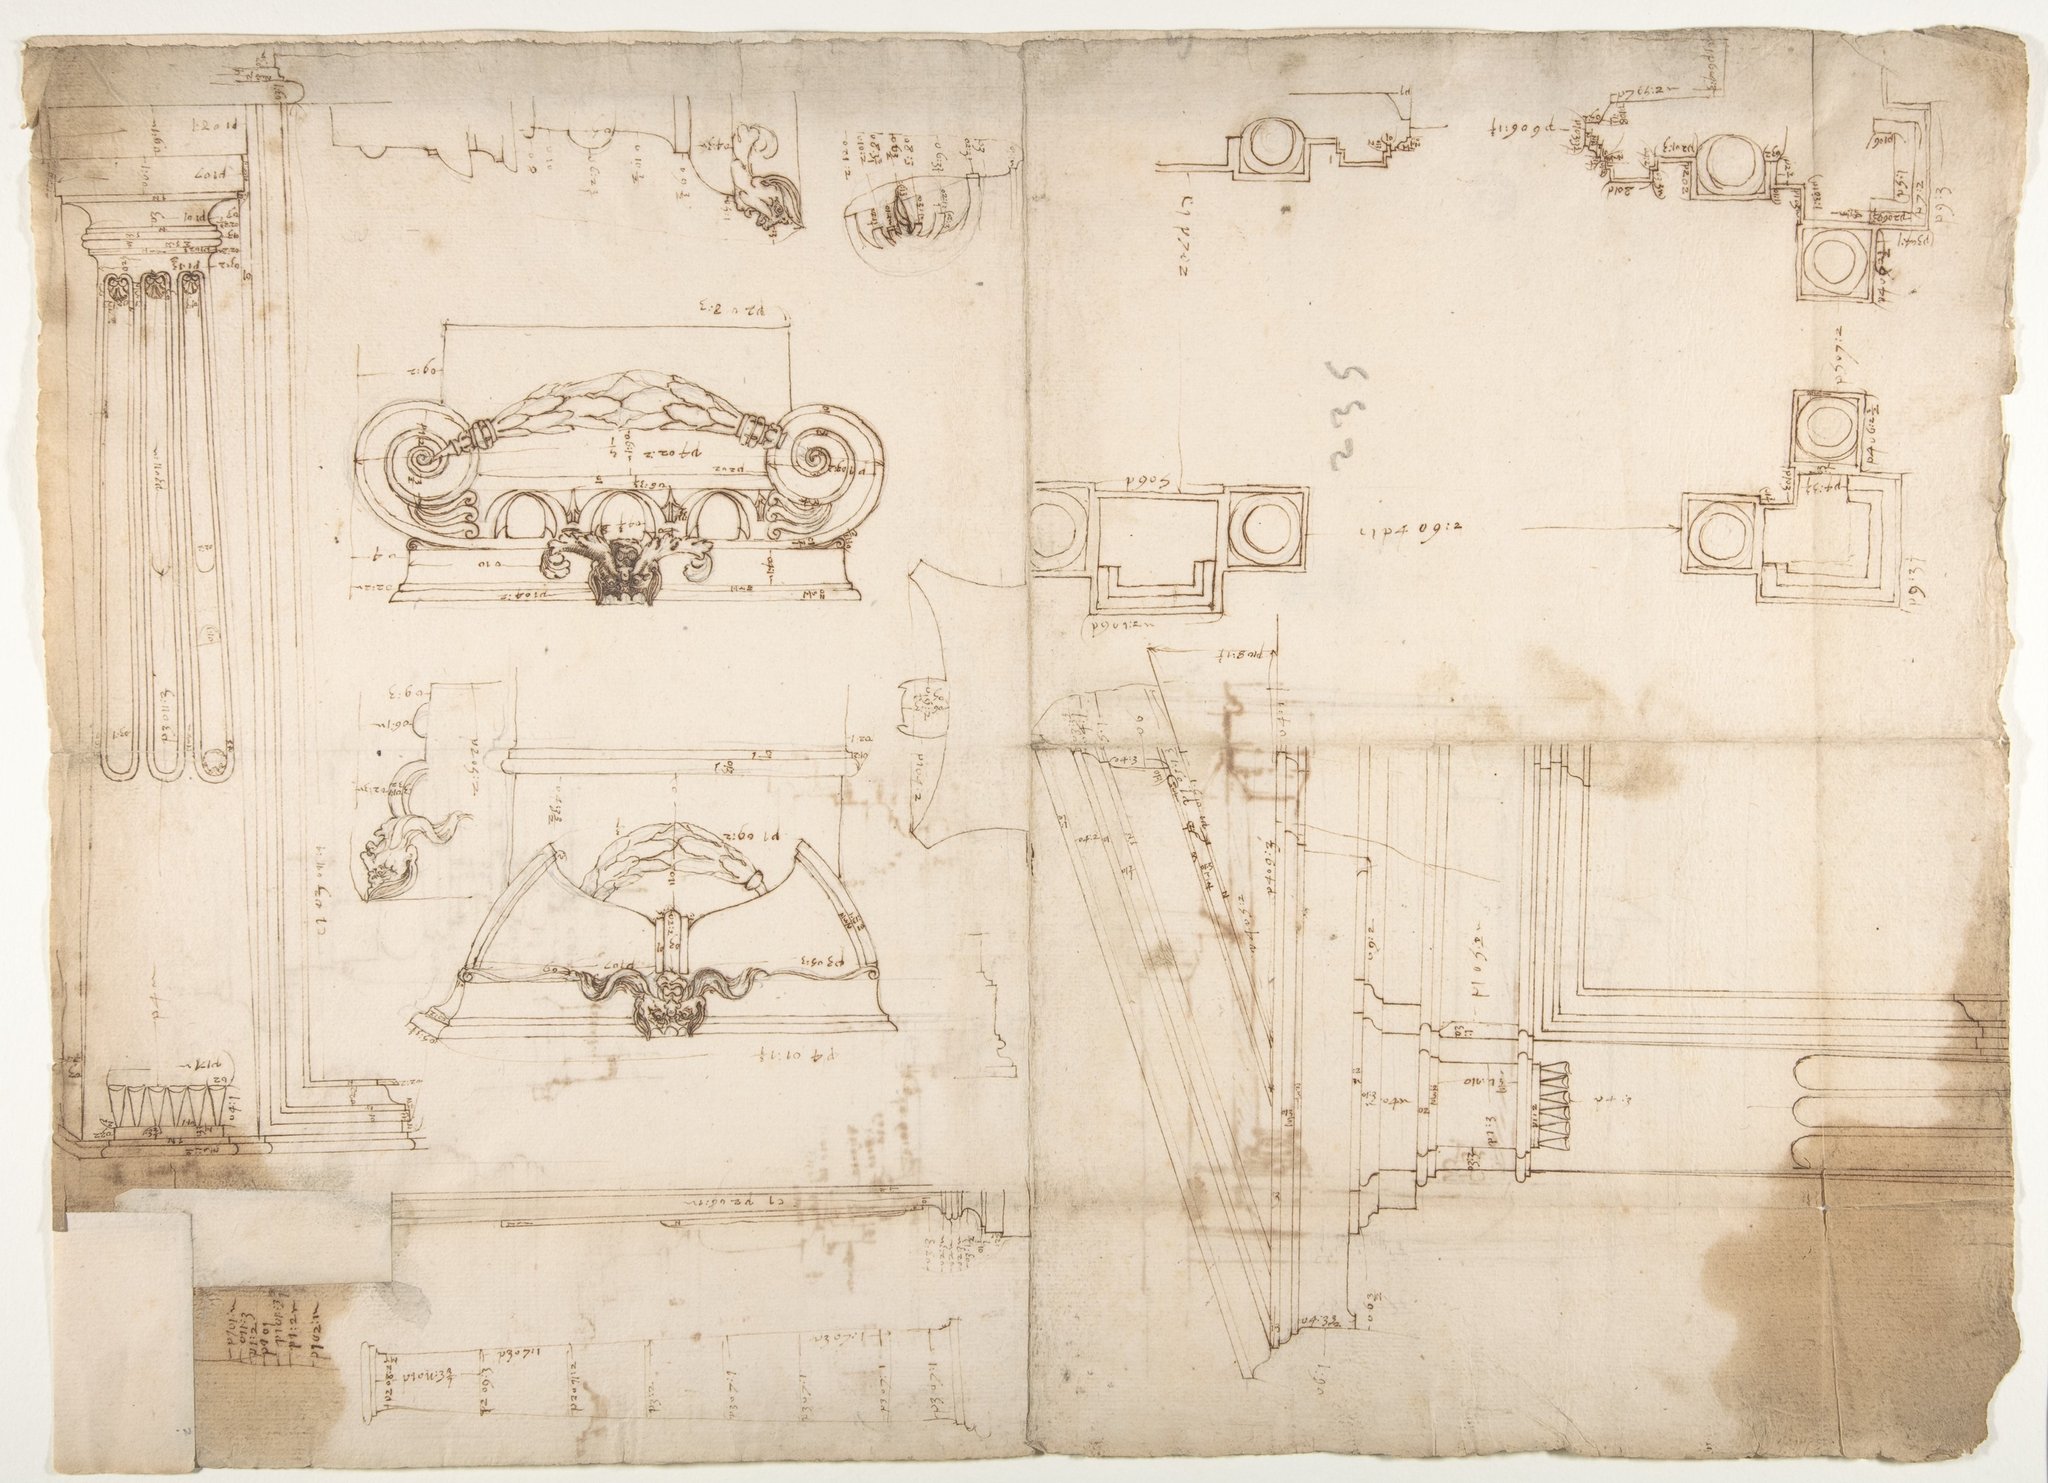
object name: drawing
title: Palazzo dei Conservatori, portico, plan; portal, elevation; details, elevations (recto) Palazzo dei Conservatori, portico, elevation; details, profiles (verso)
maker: anonymous, french, 16th century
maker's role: draftsman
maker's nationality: french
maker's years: 1500-1600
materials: chalk, ink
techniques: incising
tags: architecture